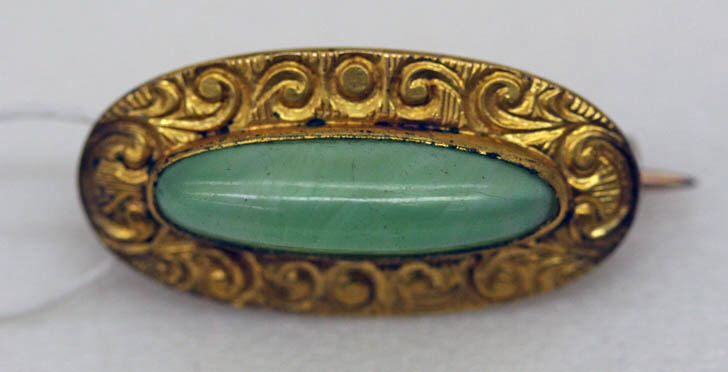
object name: brooch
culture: american or european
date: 1867-1933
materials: glass, metal